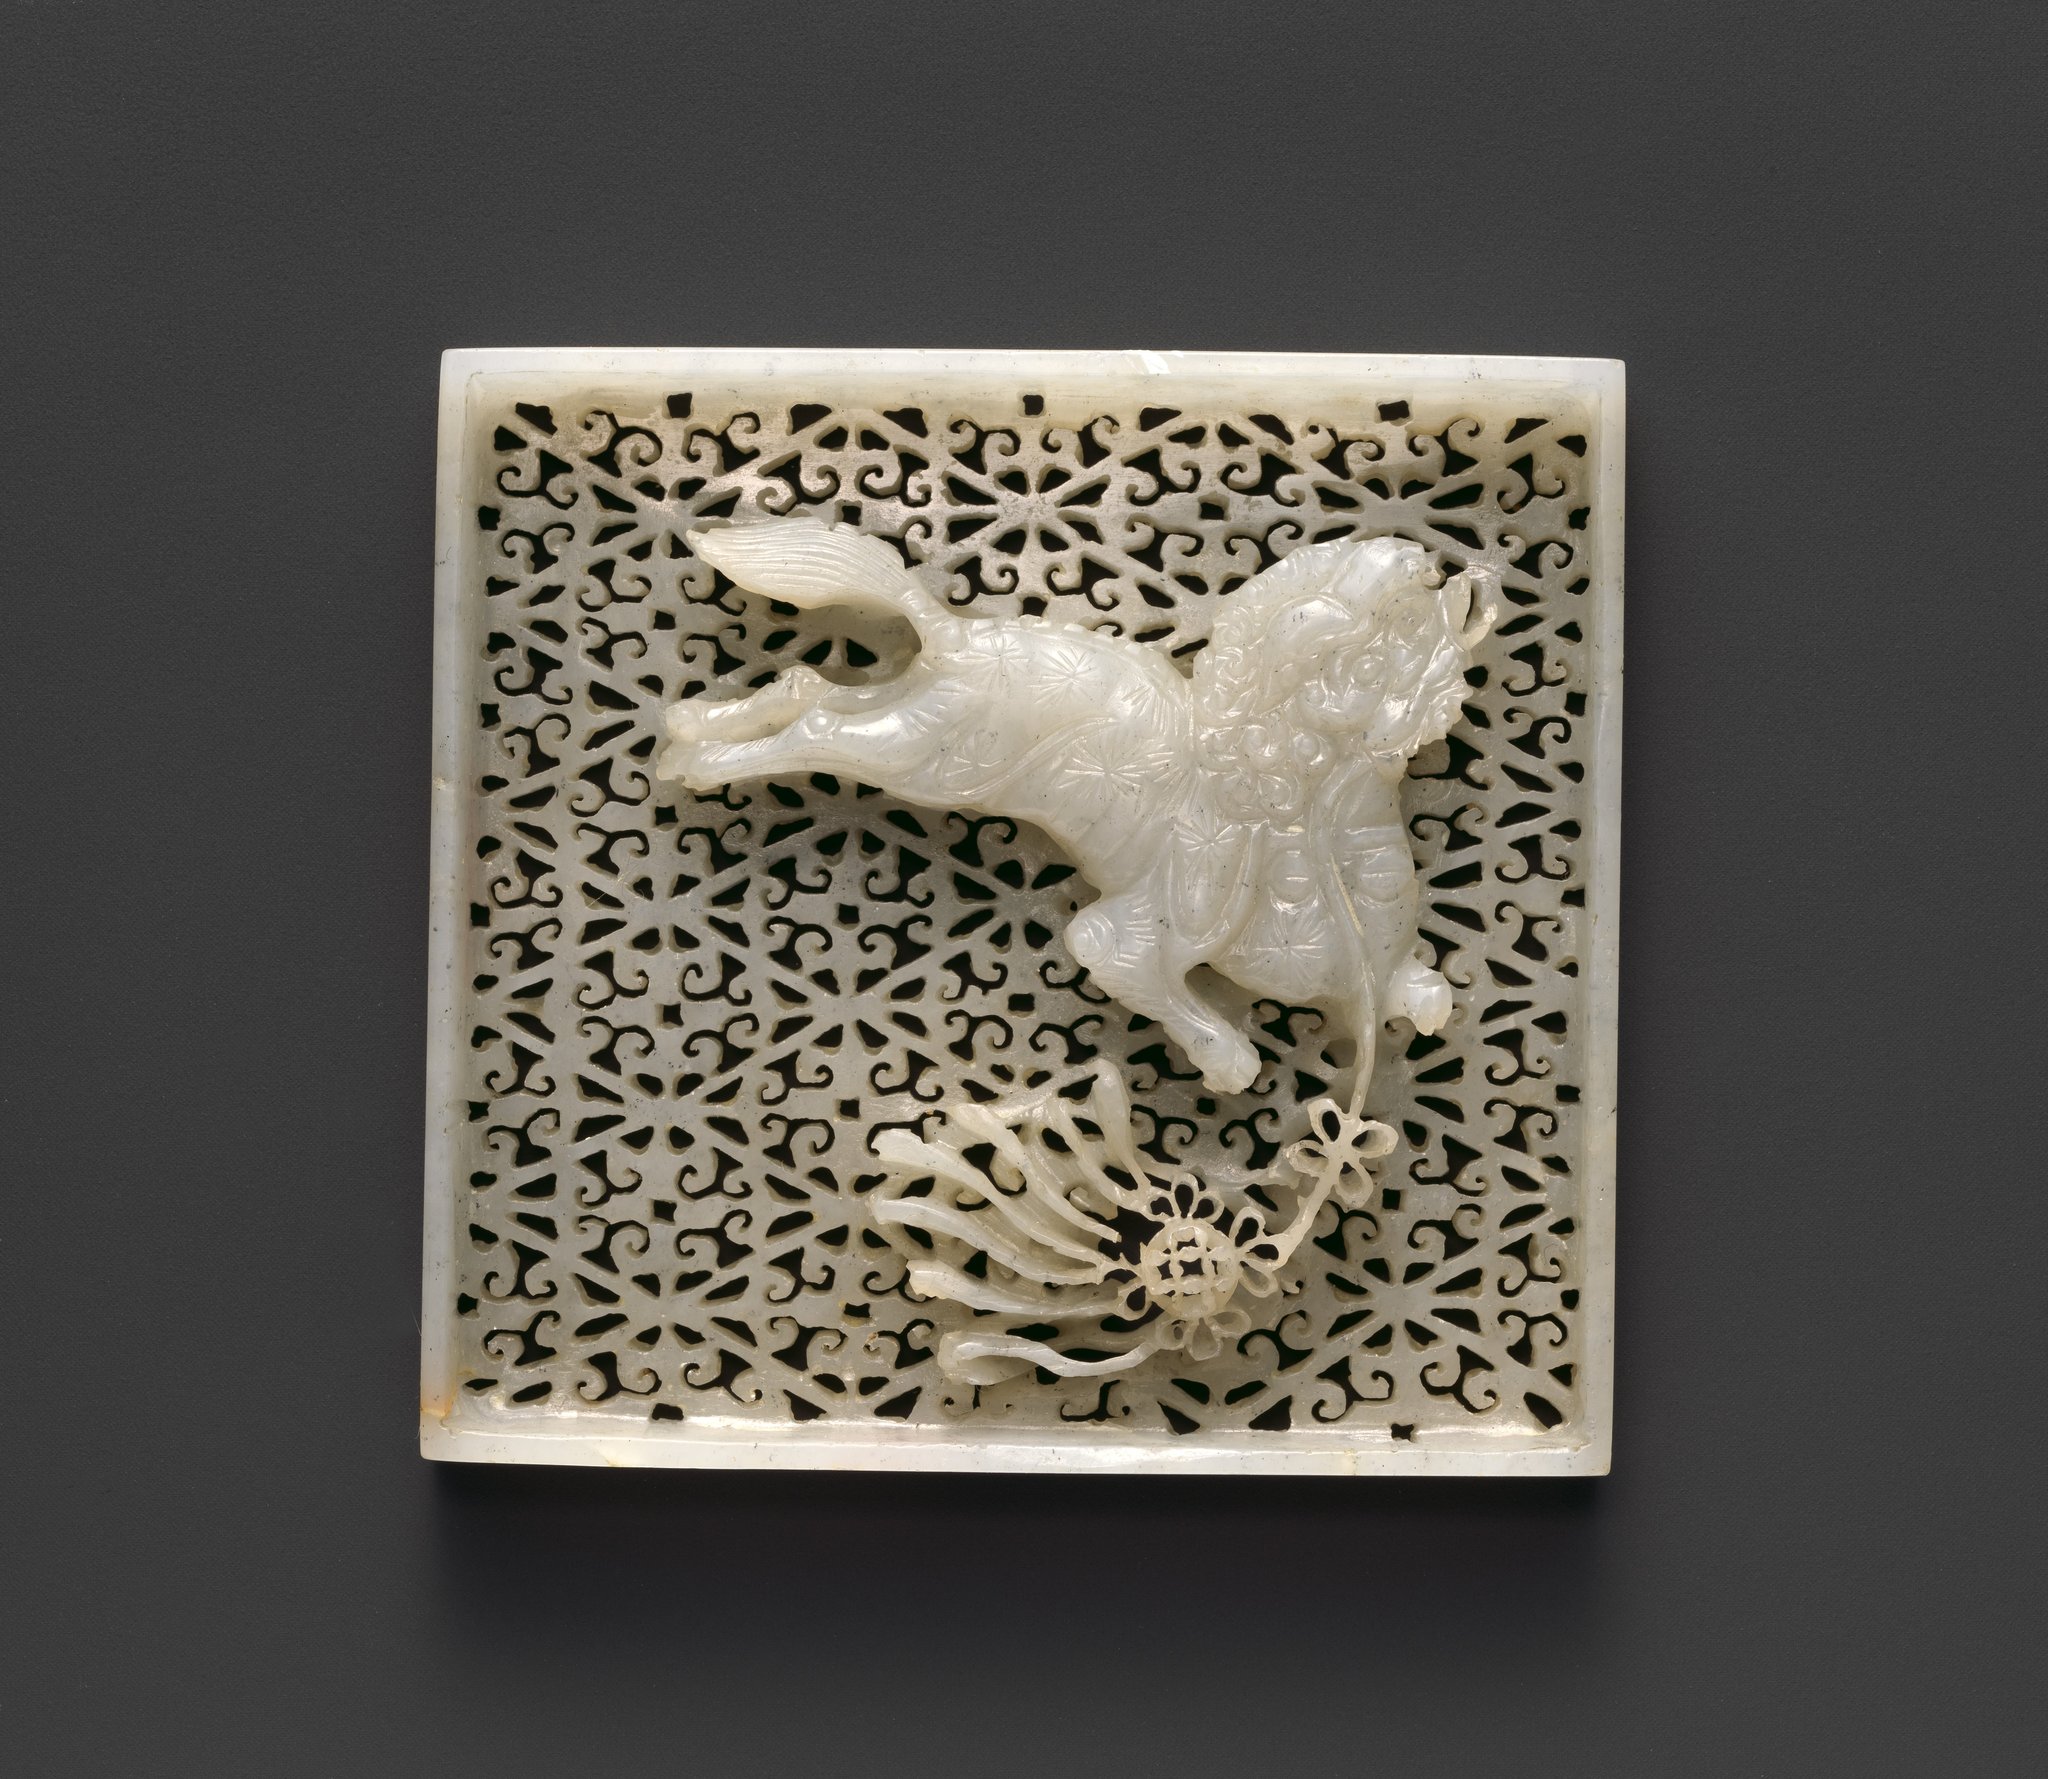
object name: belt plaque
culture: chinese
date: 1501-1700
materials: jade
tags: animals